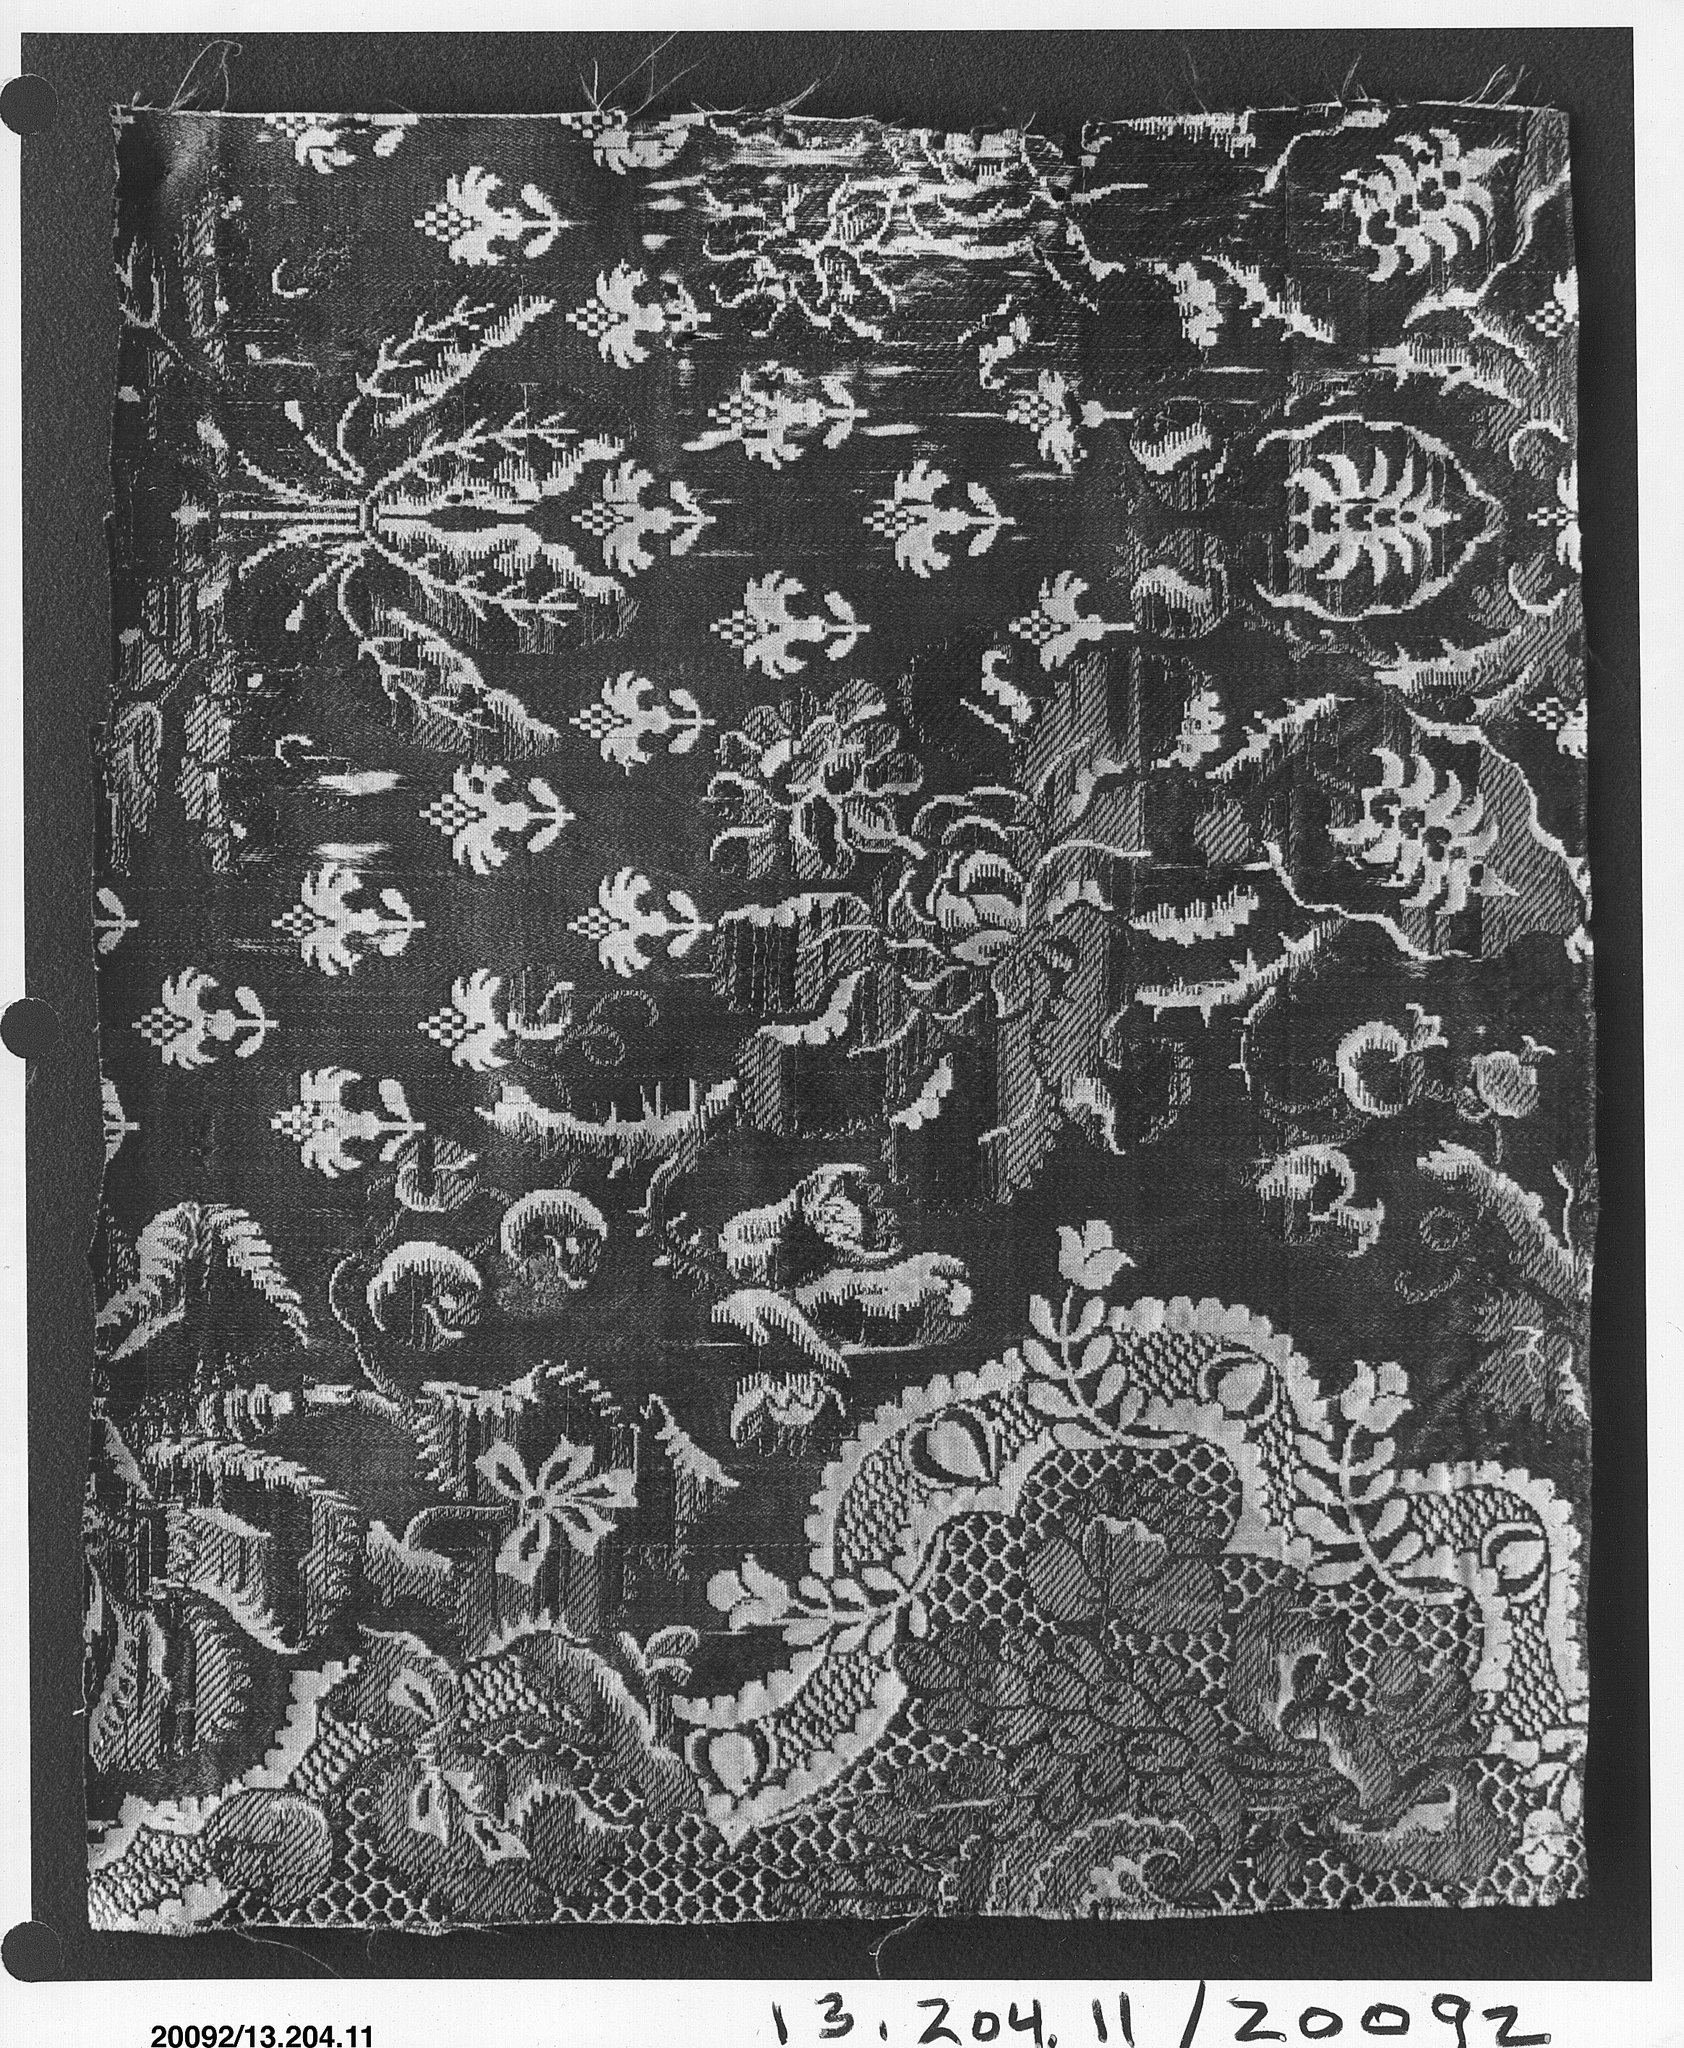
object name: fragment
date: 1601-1700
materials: silk